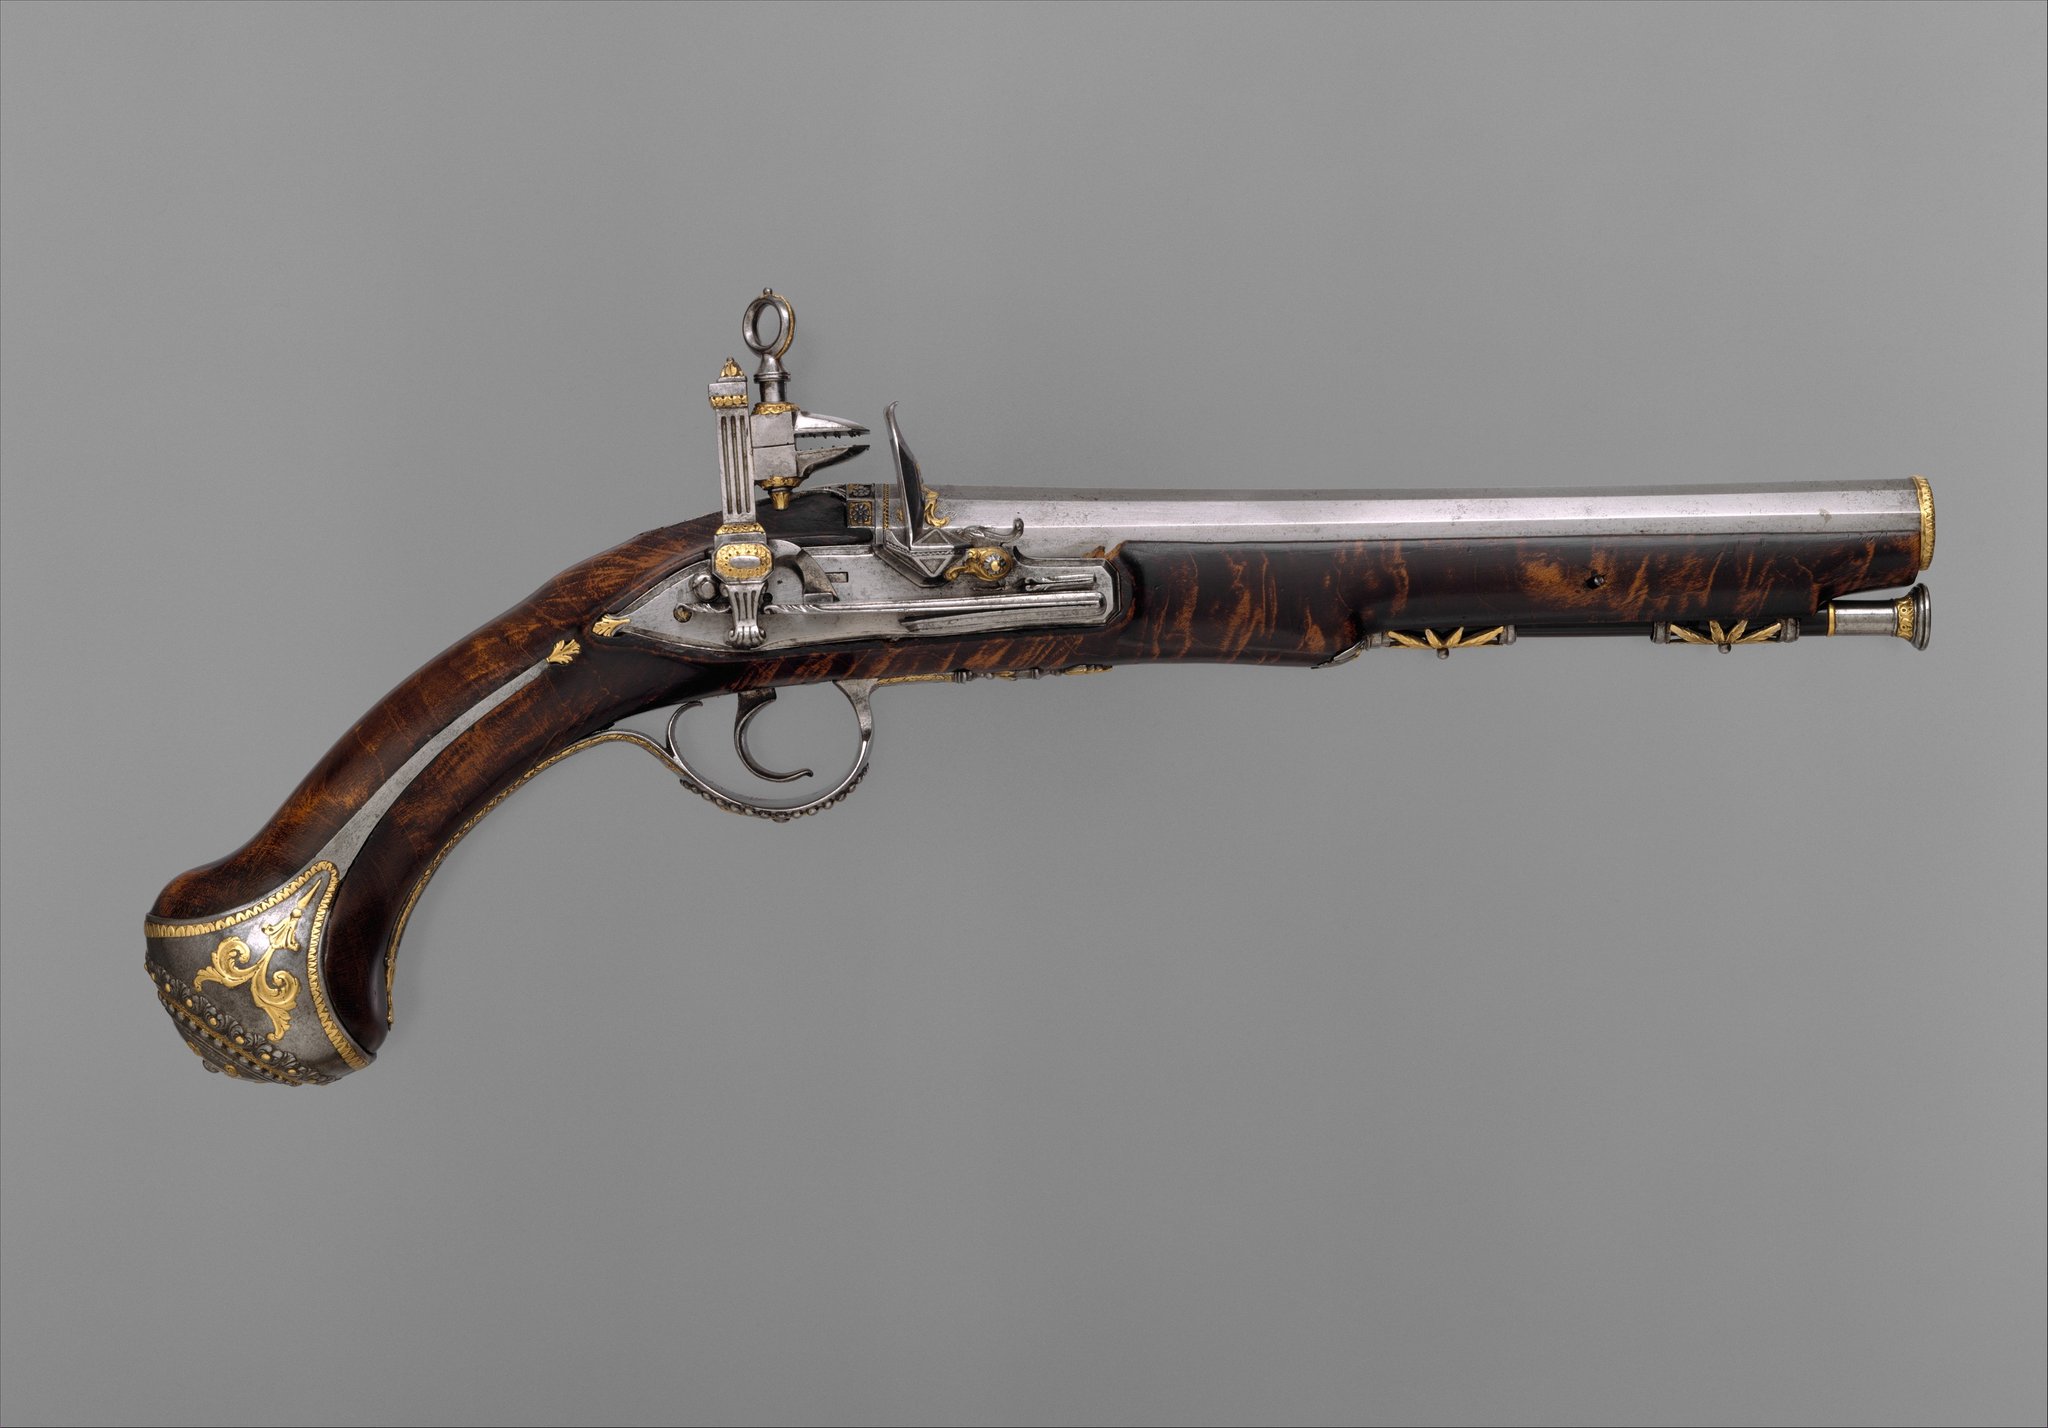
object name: miquelet pistol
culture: spanish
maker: llorens torrens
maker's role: gunsmith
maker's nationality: spanish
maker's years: 1793-1824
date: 1790-1807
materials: gold, steel, wood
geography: spain